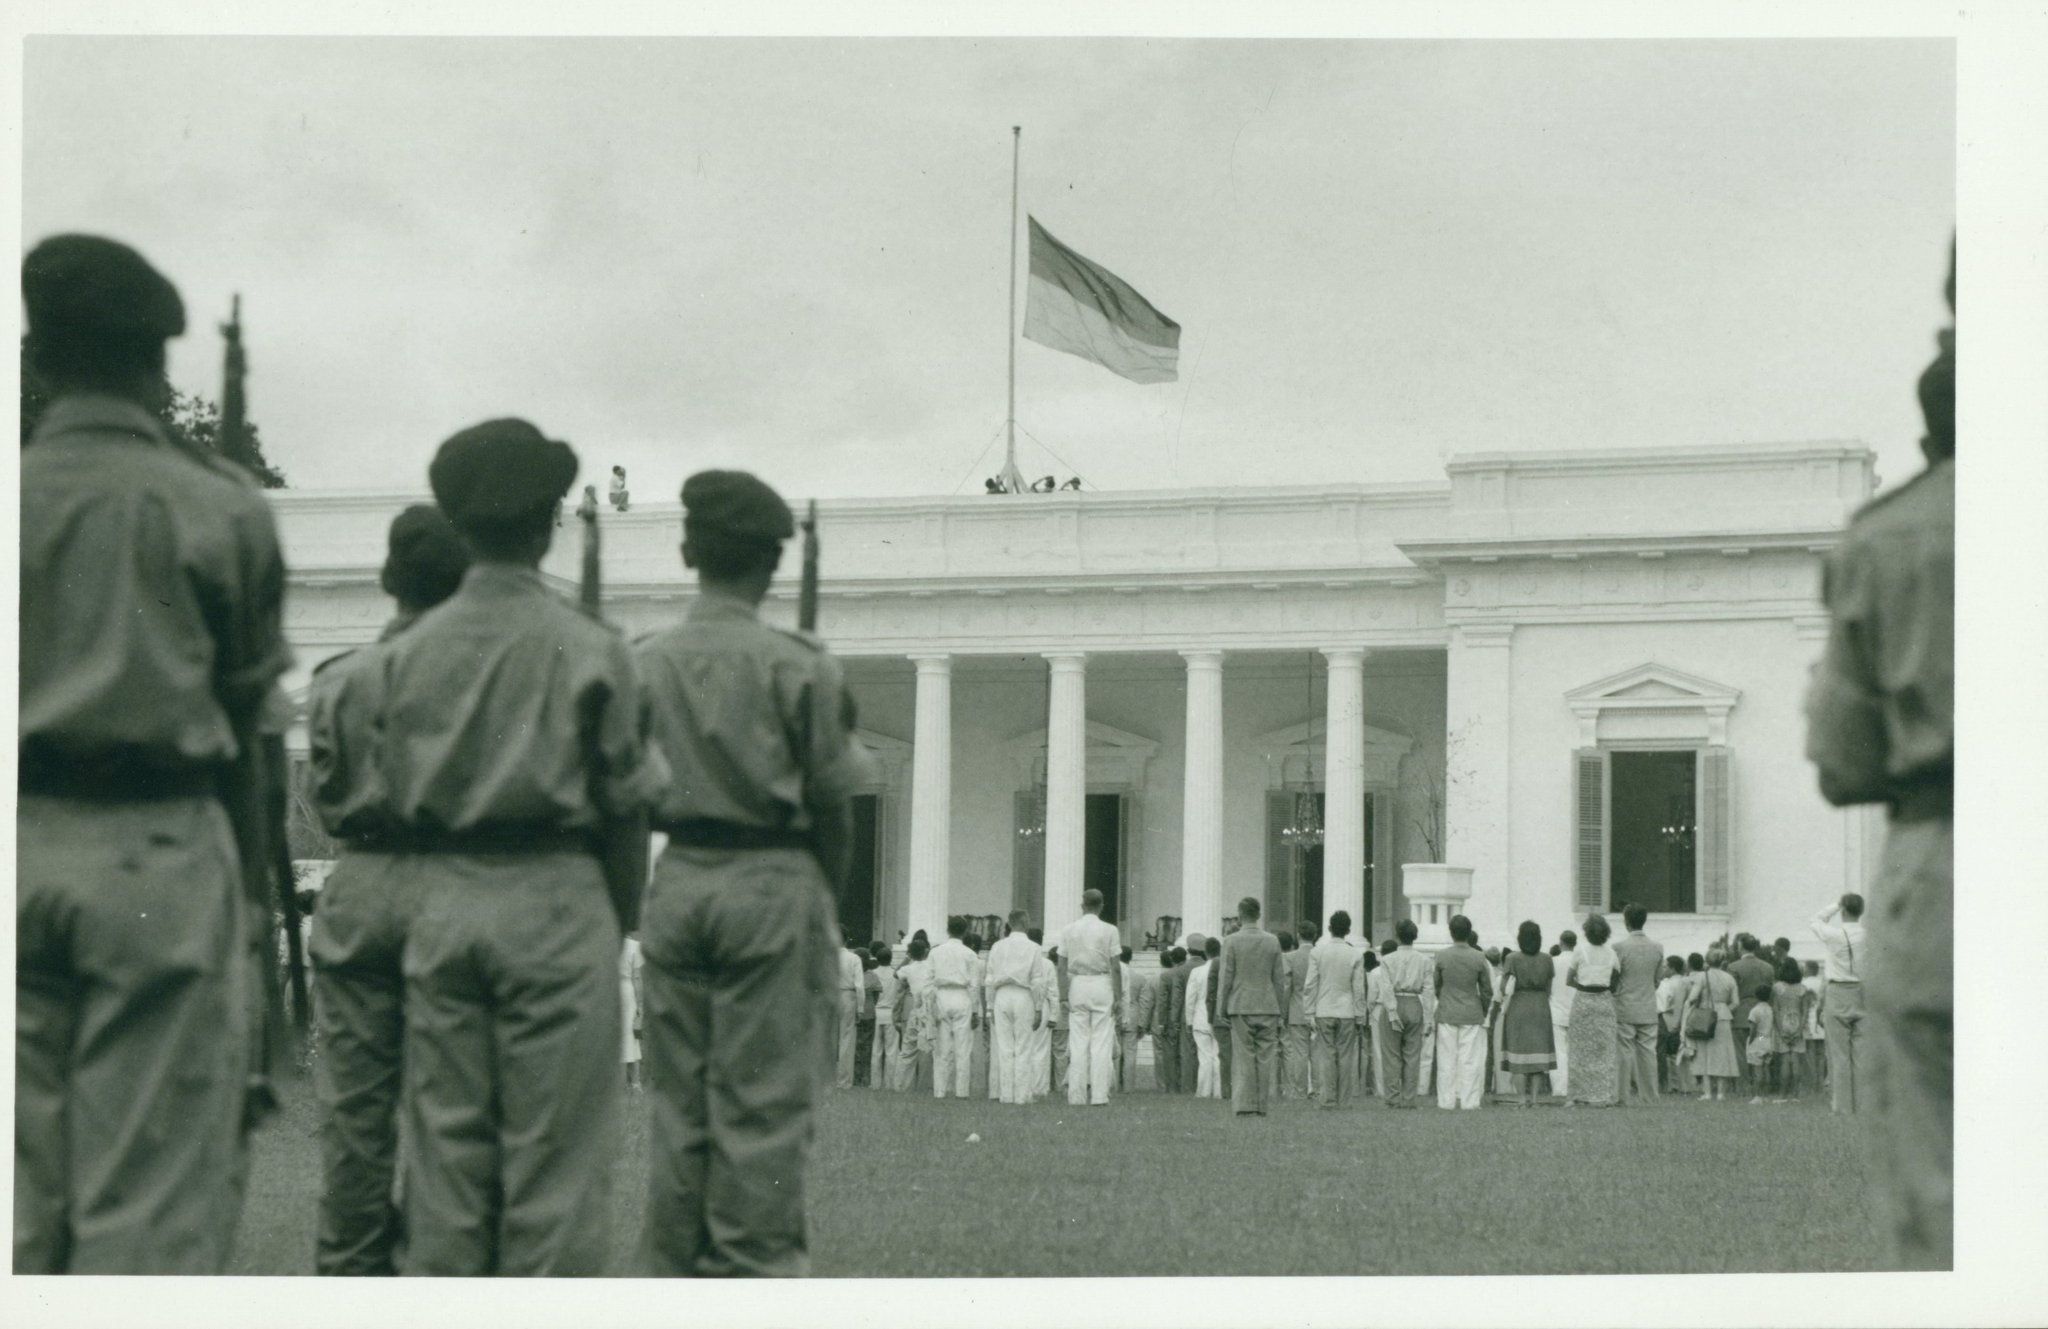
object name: documentary photograph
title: Onder veel ceremonieel vertoon hijst men de Indonesische vlag op het paleis van de HVK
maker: willem boshouwers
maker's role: fotograaf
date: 1949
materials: photographic support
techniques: photography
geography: batavia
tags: the hague, batavia, transfer of sovereignty to indonesia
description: Met op de voorgrond een strak in het gelid staande formatie van soldaten, daarachter een groep belangstellenden op het gazon net voor het paleis van de Hoge Vertegenwoordiger van de Kroon. Op het dak van het paleis salueert een aantal soldaten tijdens het hijsen van de vlag, daarbij nauwlettend gade geslagen door een links op de dakrand zittende fotograaf. Net daarvoor werd om 17:51 uur plaatselijke tijd de Nederlandse vlag gestreken door de toenmalige HVK de heer Lovink, waarna de rood-witte vlag van de Indonesische Republiek werd gehesen.